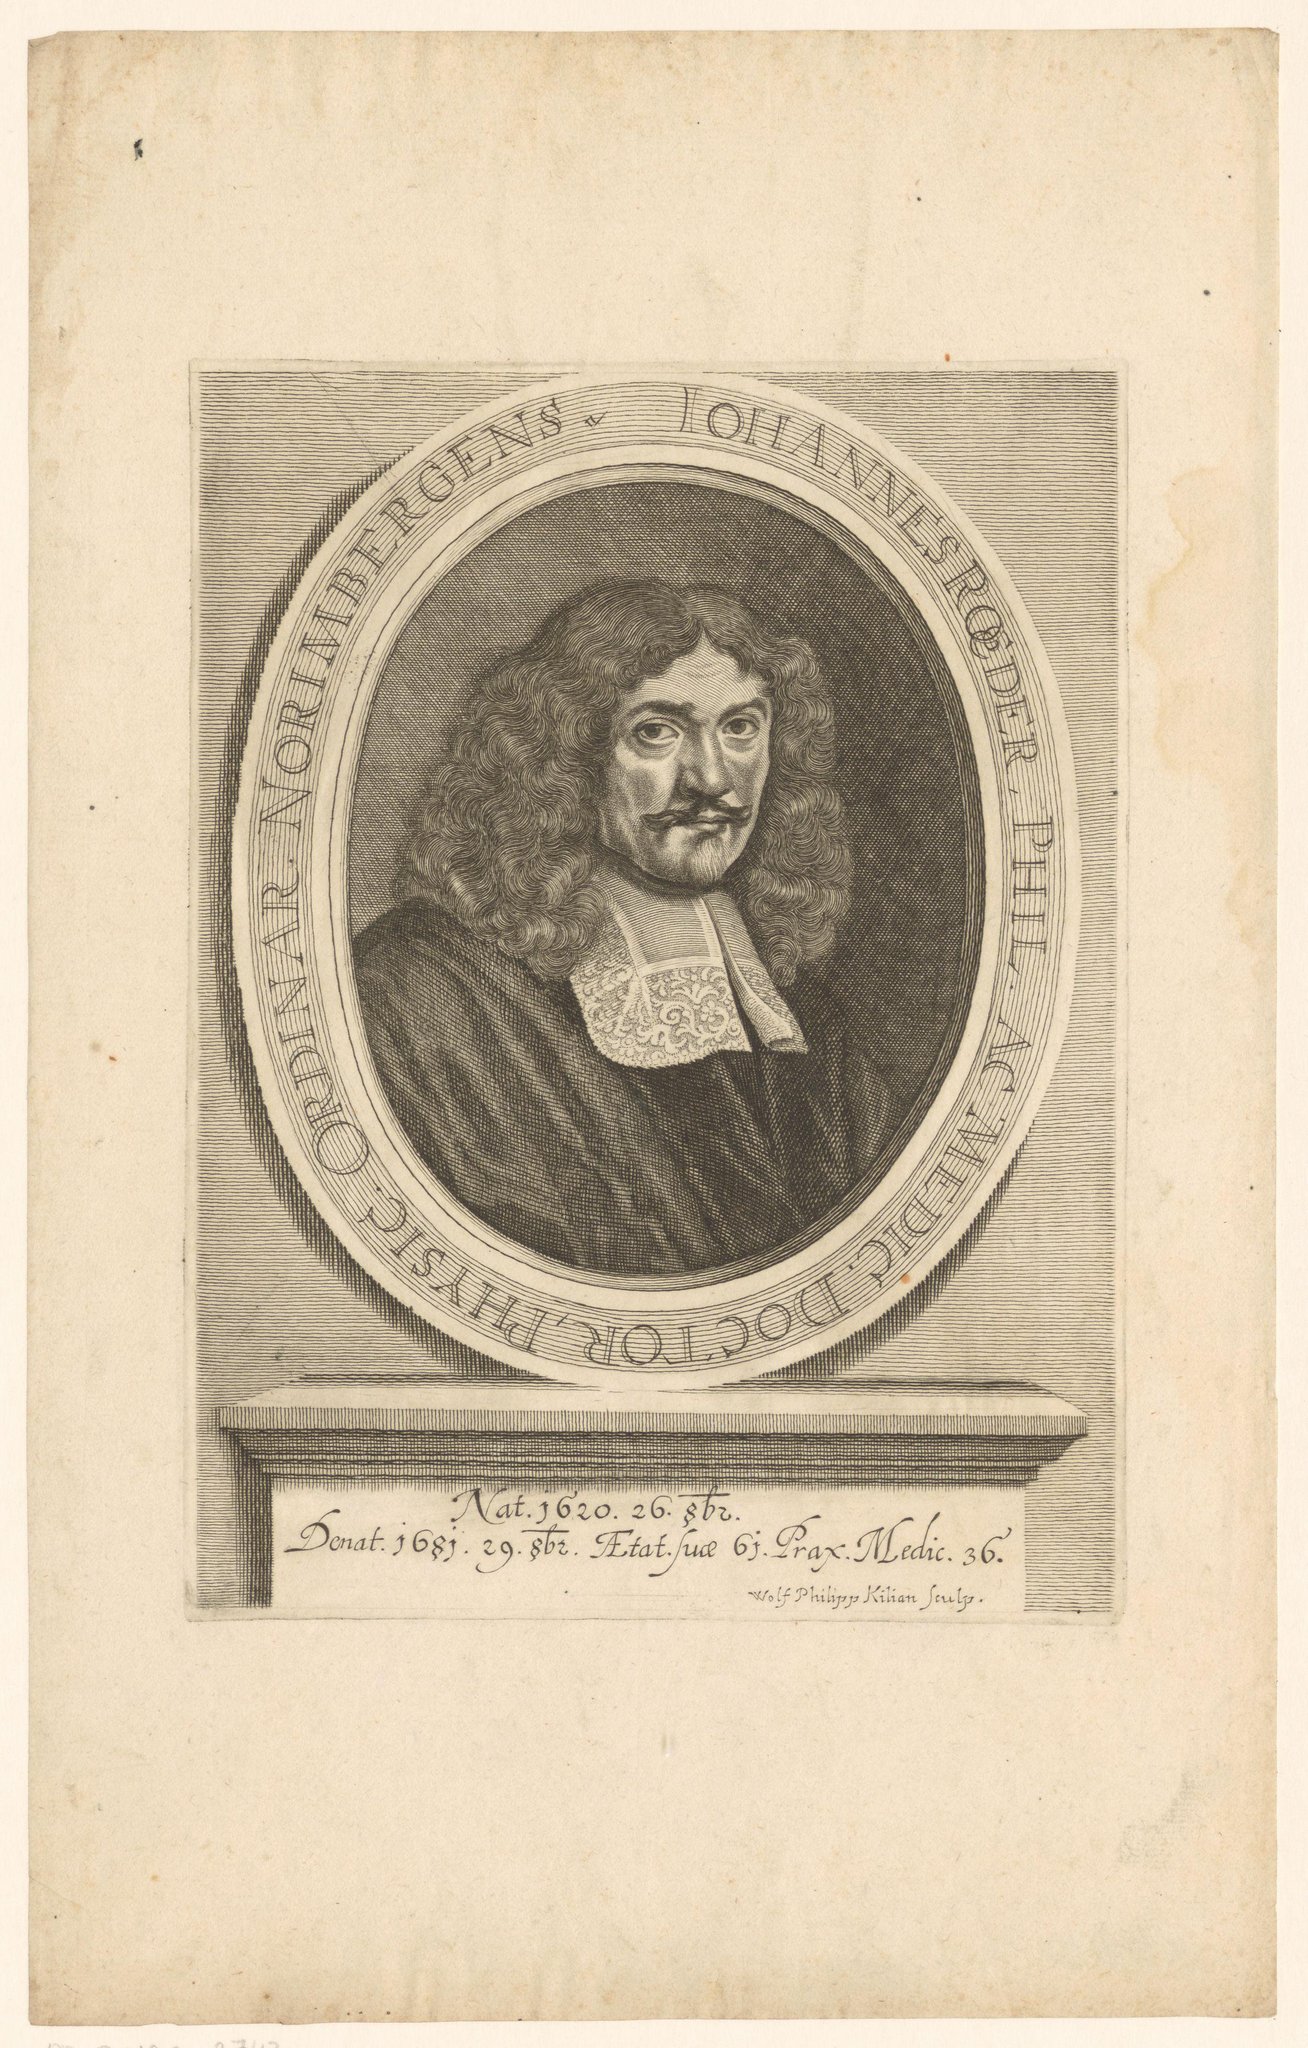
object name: print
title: Portret van Johann Röder op 61-jarige leeftijd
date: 1681-1732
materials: paper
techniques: engraving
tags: historical persons, physician, doctor (+ portrait of scholar, scientist)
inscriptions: collector's mark: Lugt 2228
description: Tekst in het Latijn in de omlijsting en in de ondermarge.